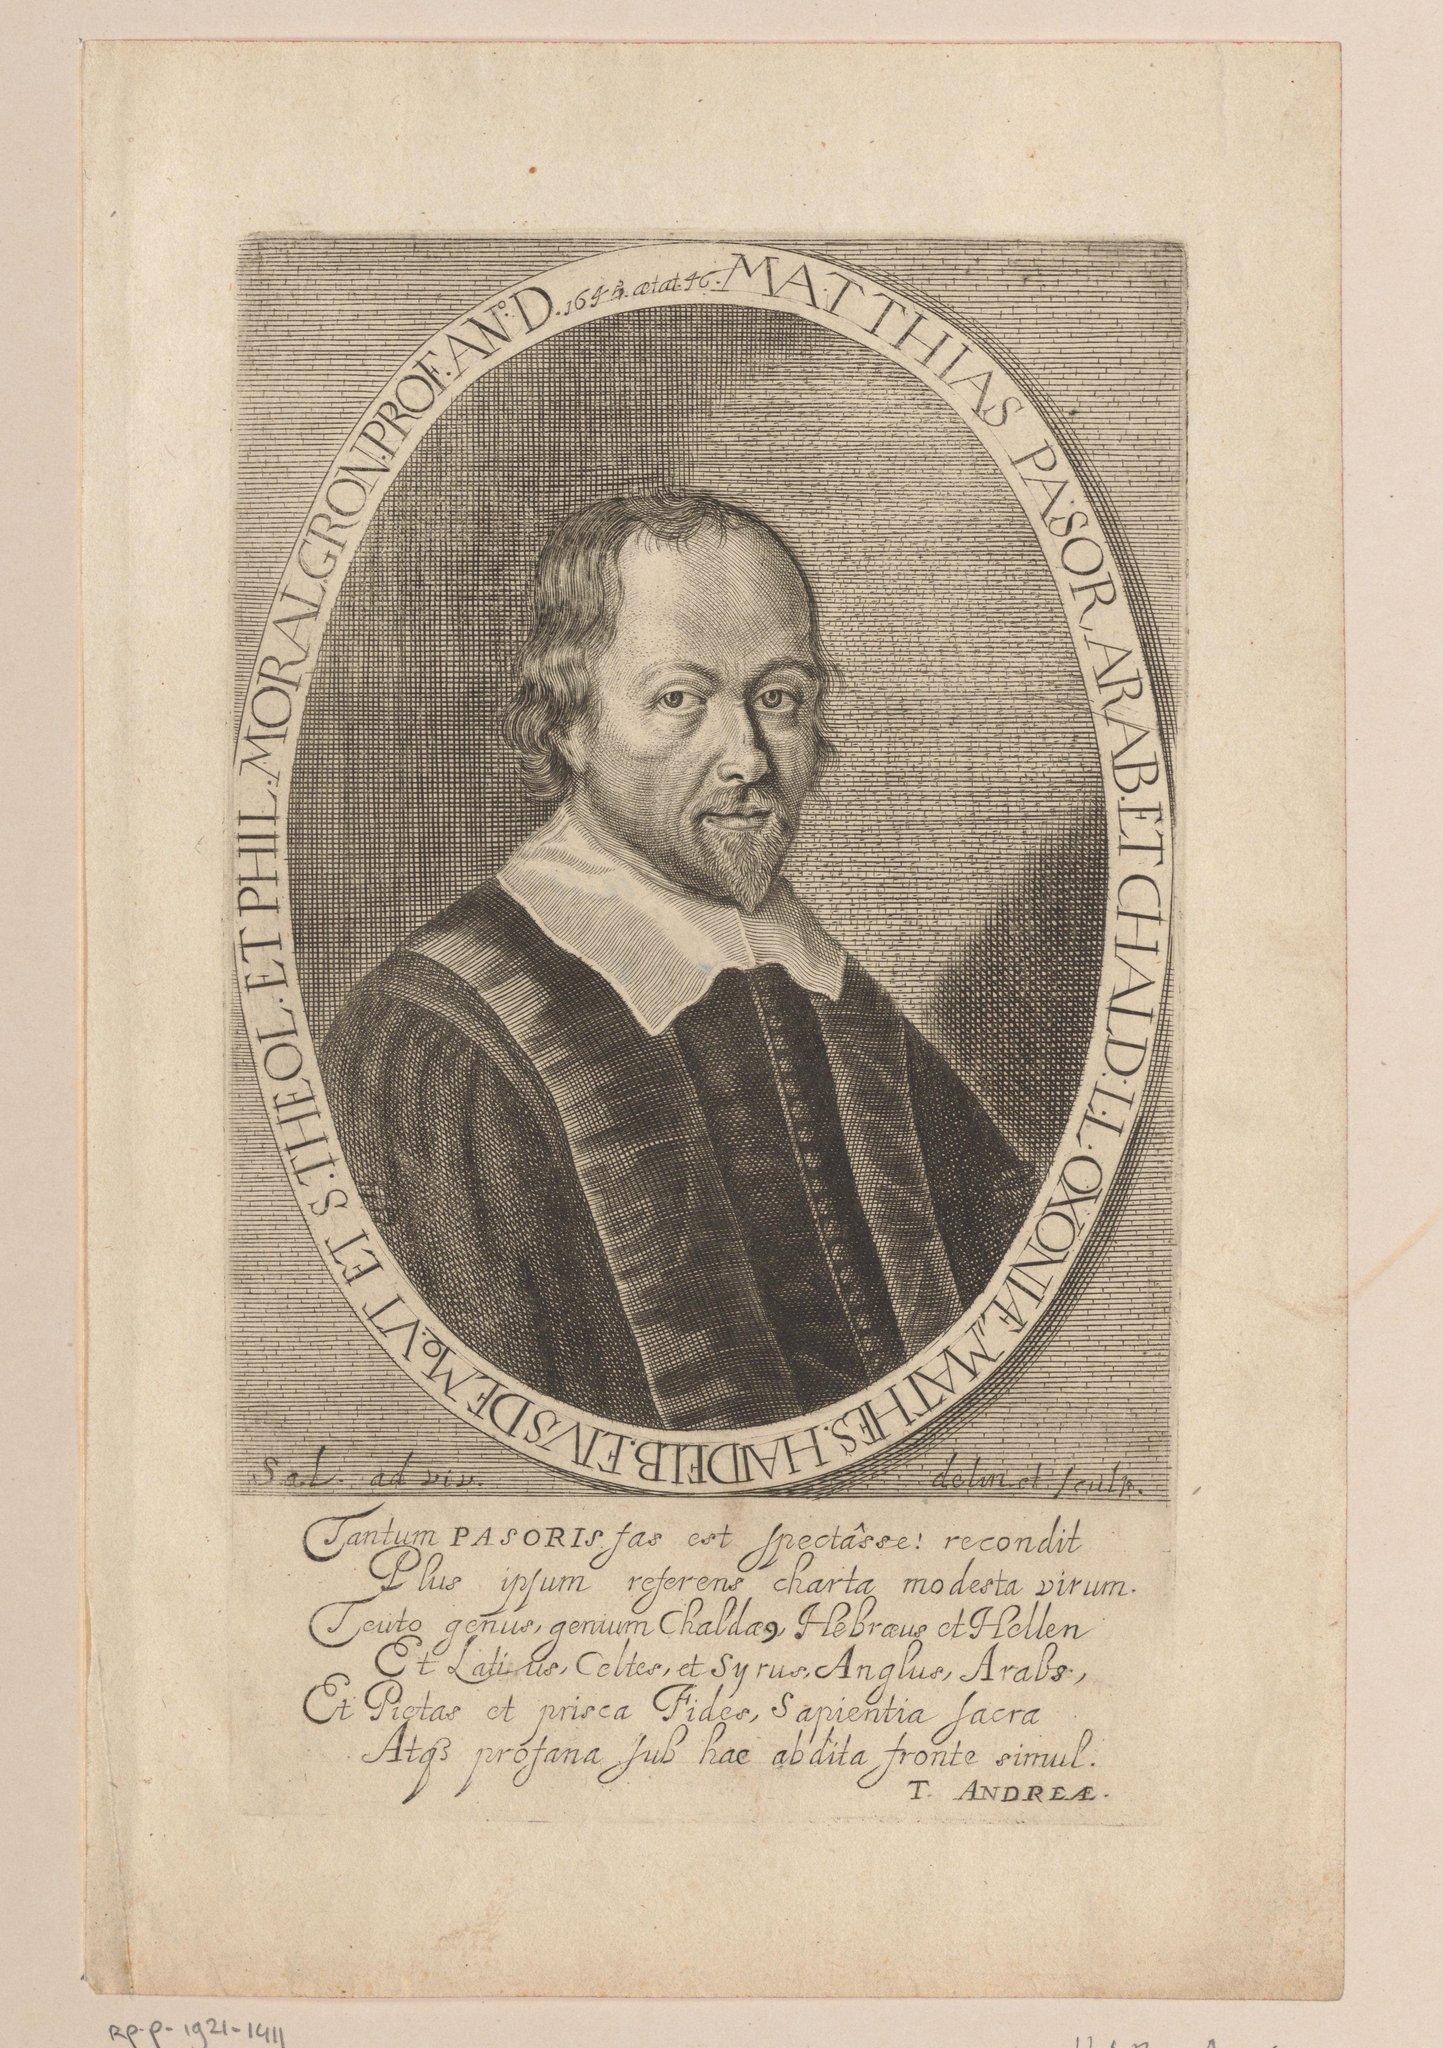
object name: print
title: Portret van Matthias Pasor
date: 1654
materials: paper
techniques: engraving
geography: groningen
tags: matthias pasor, adult man, historical persons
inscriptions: collector's mark: Lugt 2233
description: Prent uit: Effigies & vitae Professorvm Academiae Groningae & Omlandiae. Groningen: Hindrick Lussinck en Jan Claessen, 1654.